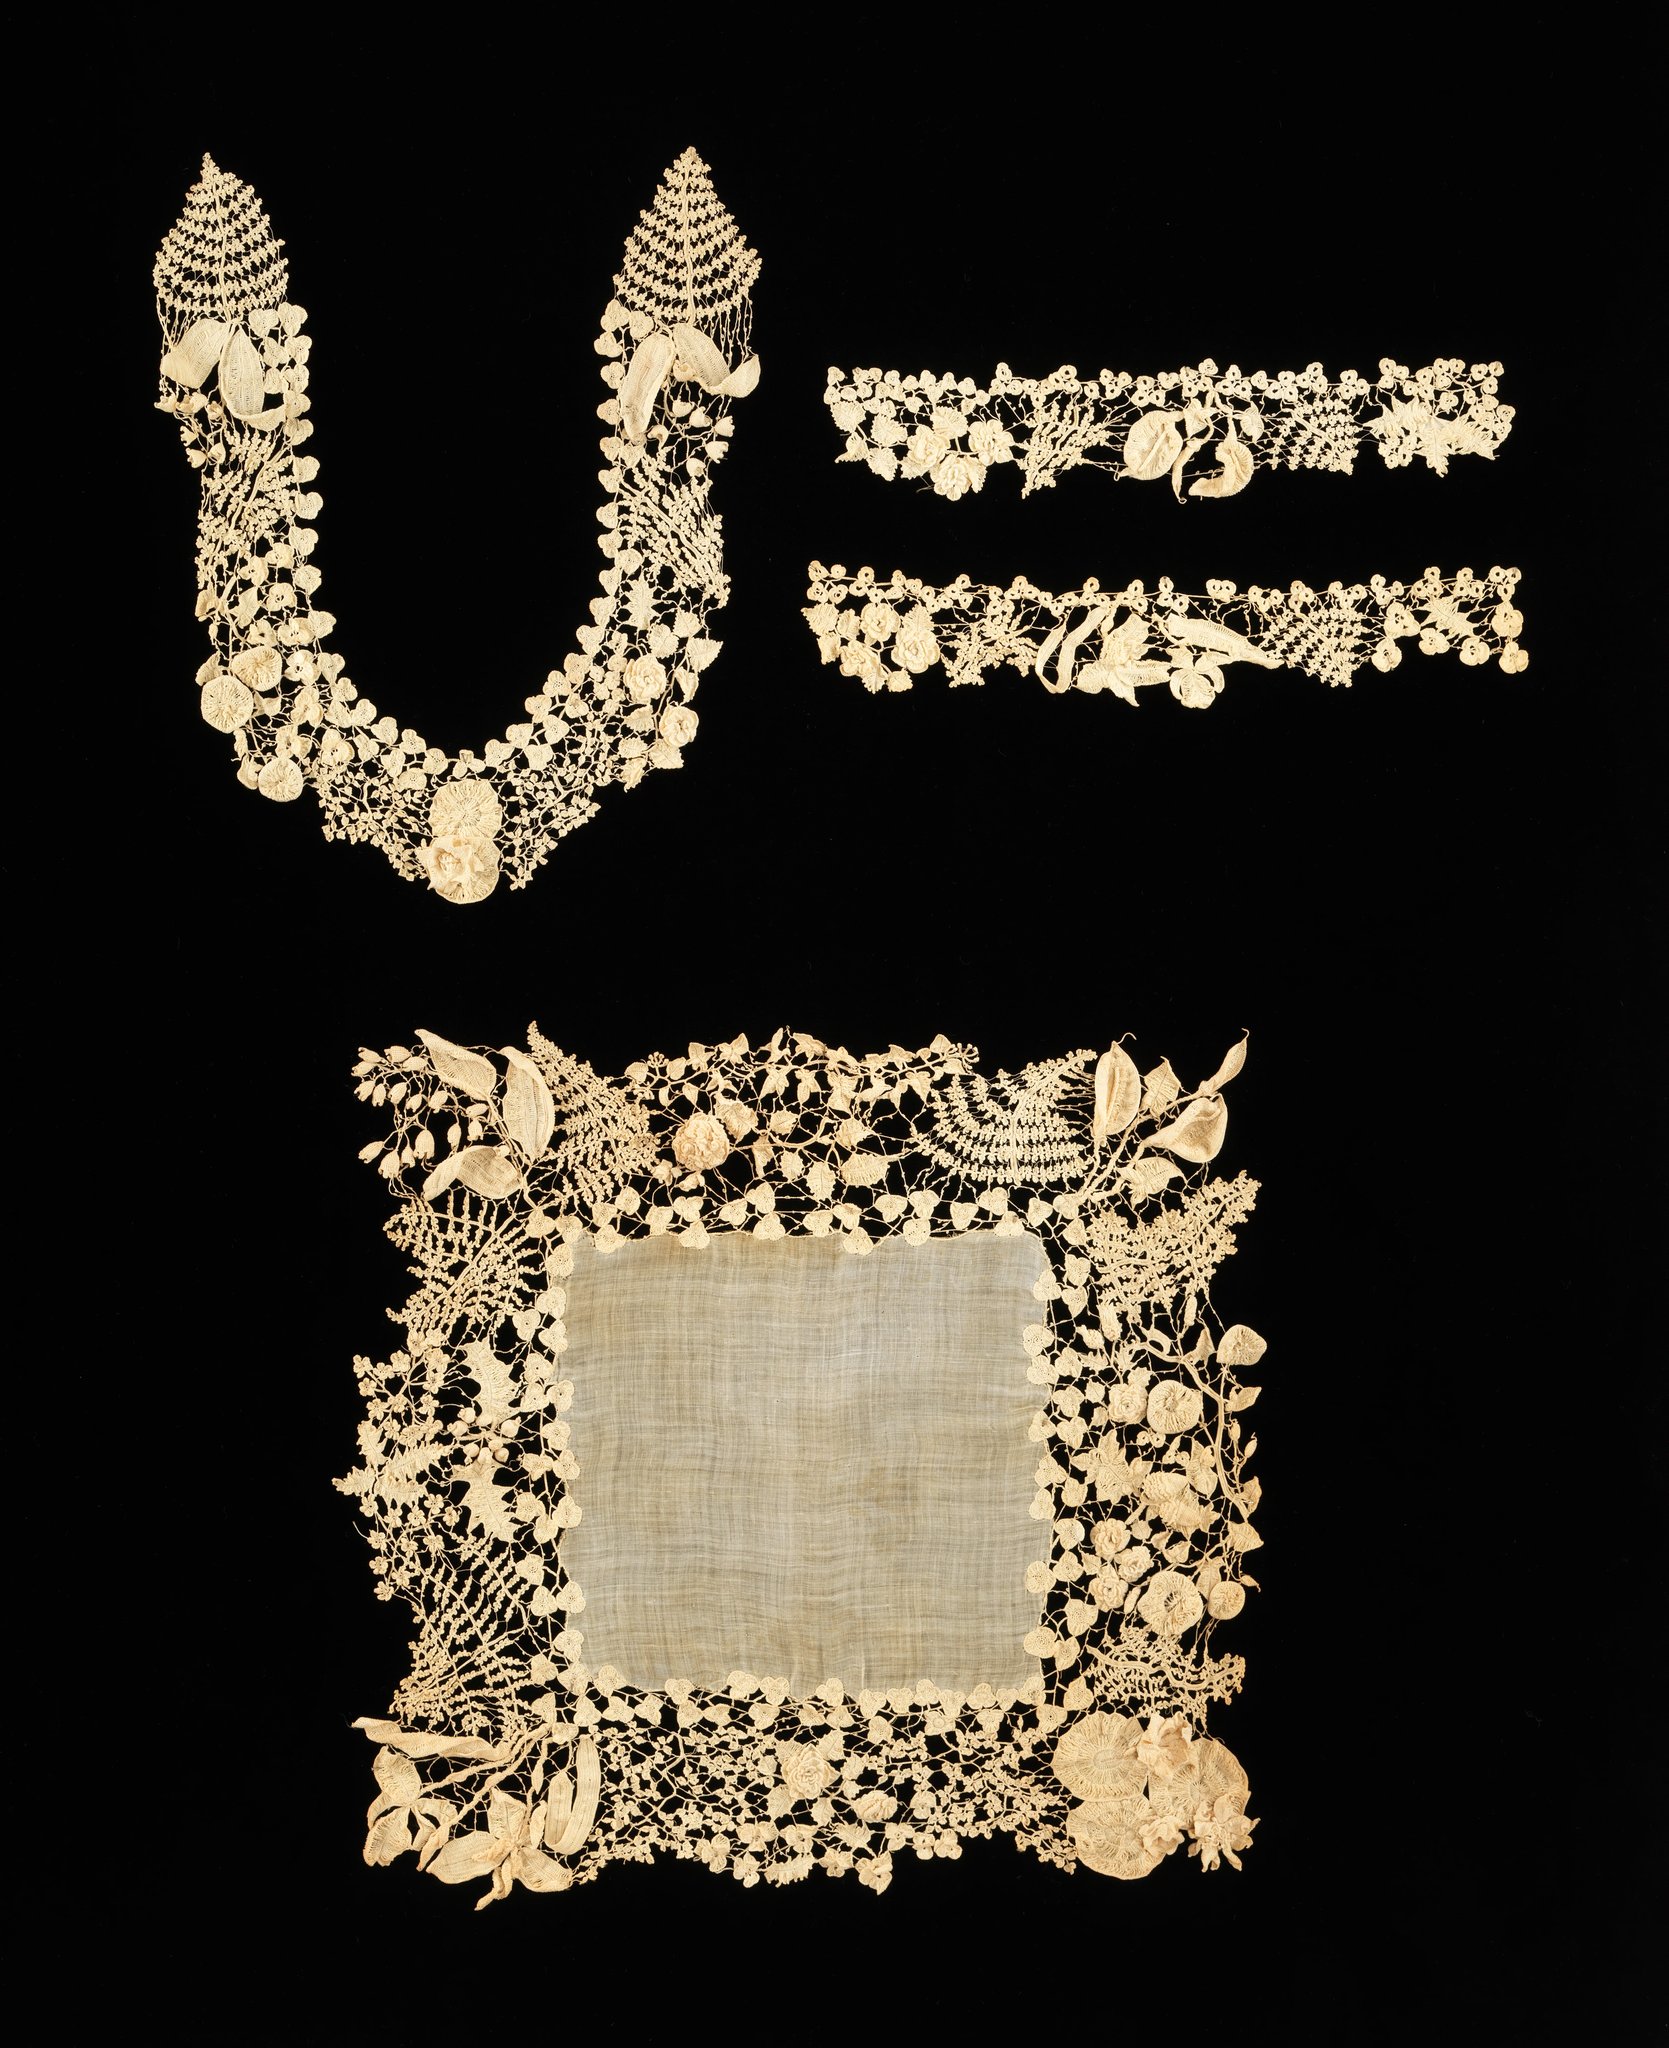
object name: accessory set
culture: irish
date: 1850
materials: cotton